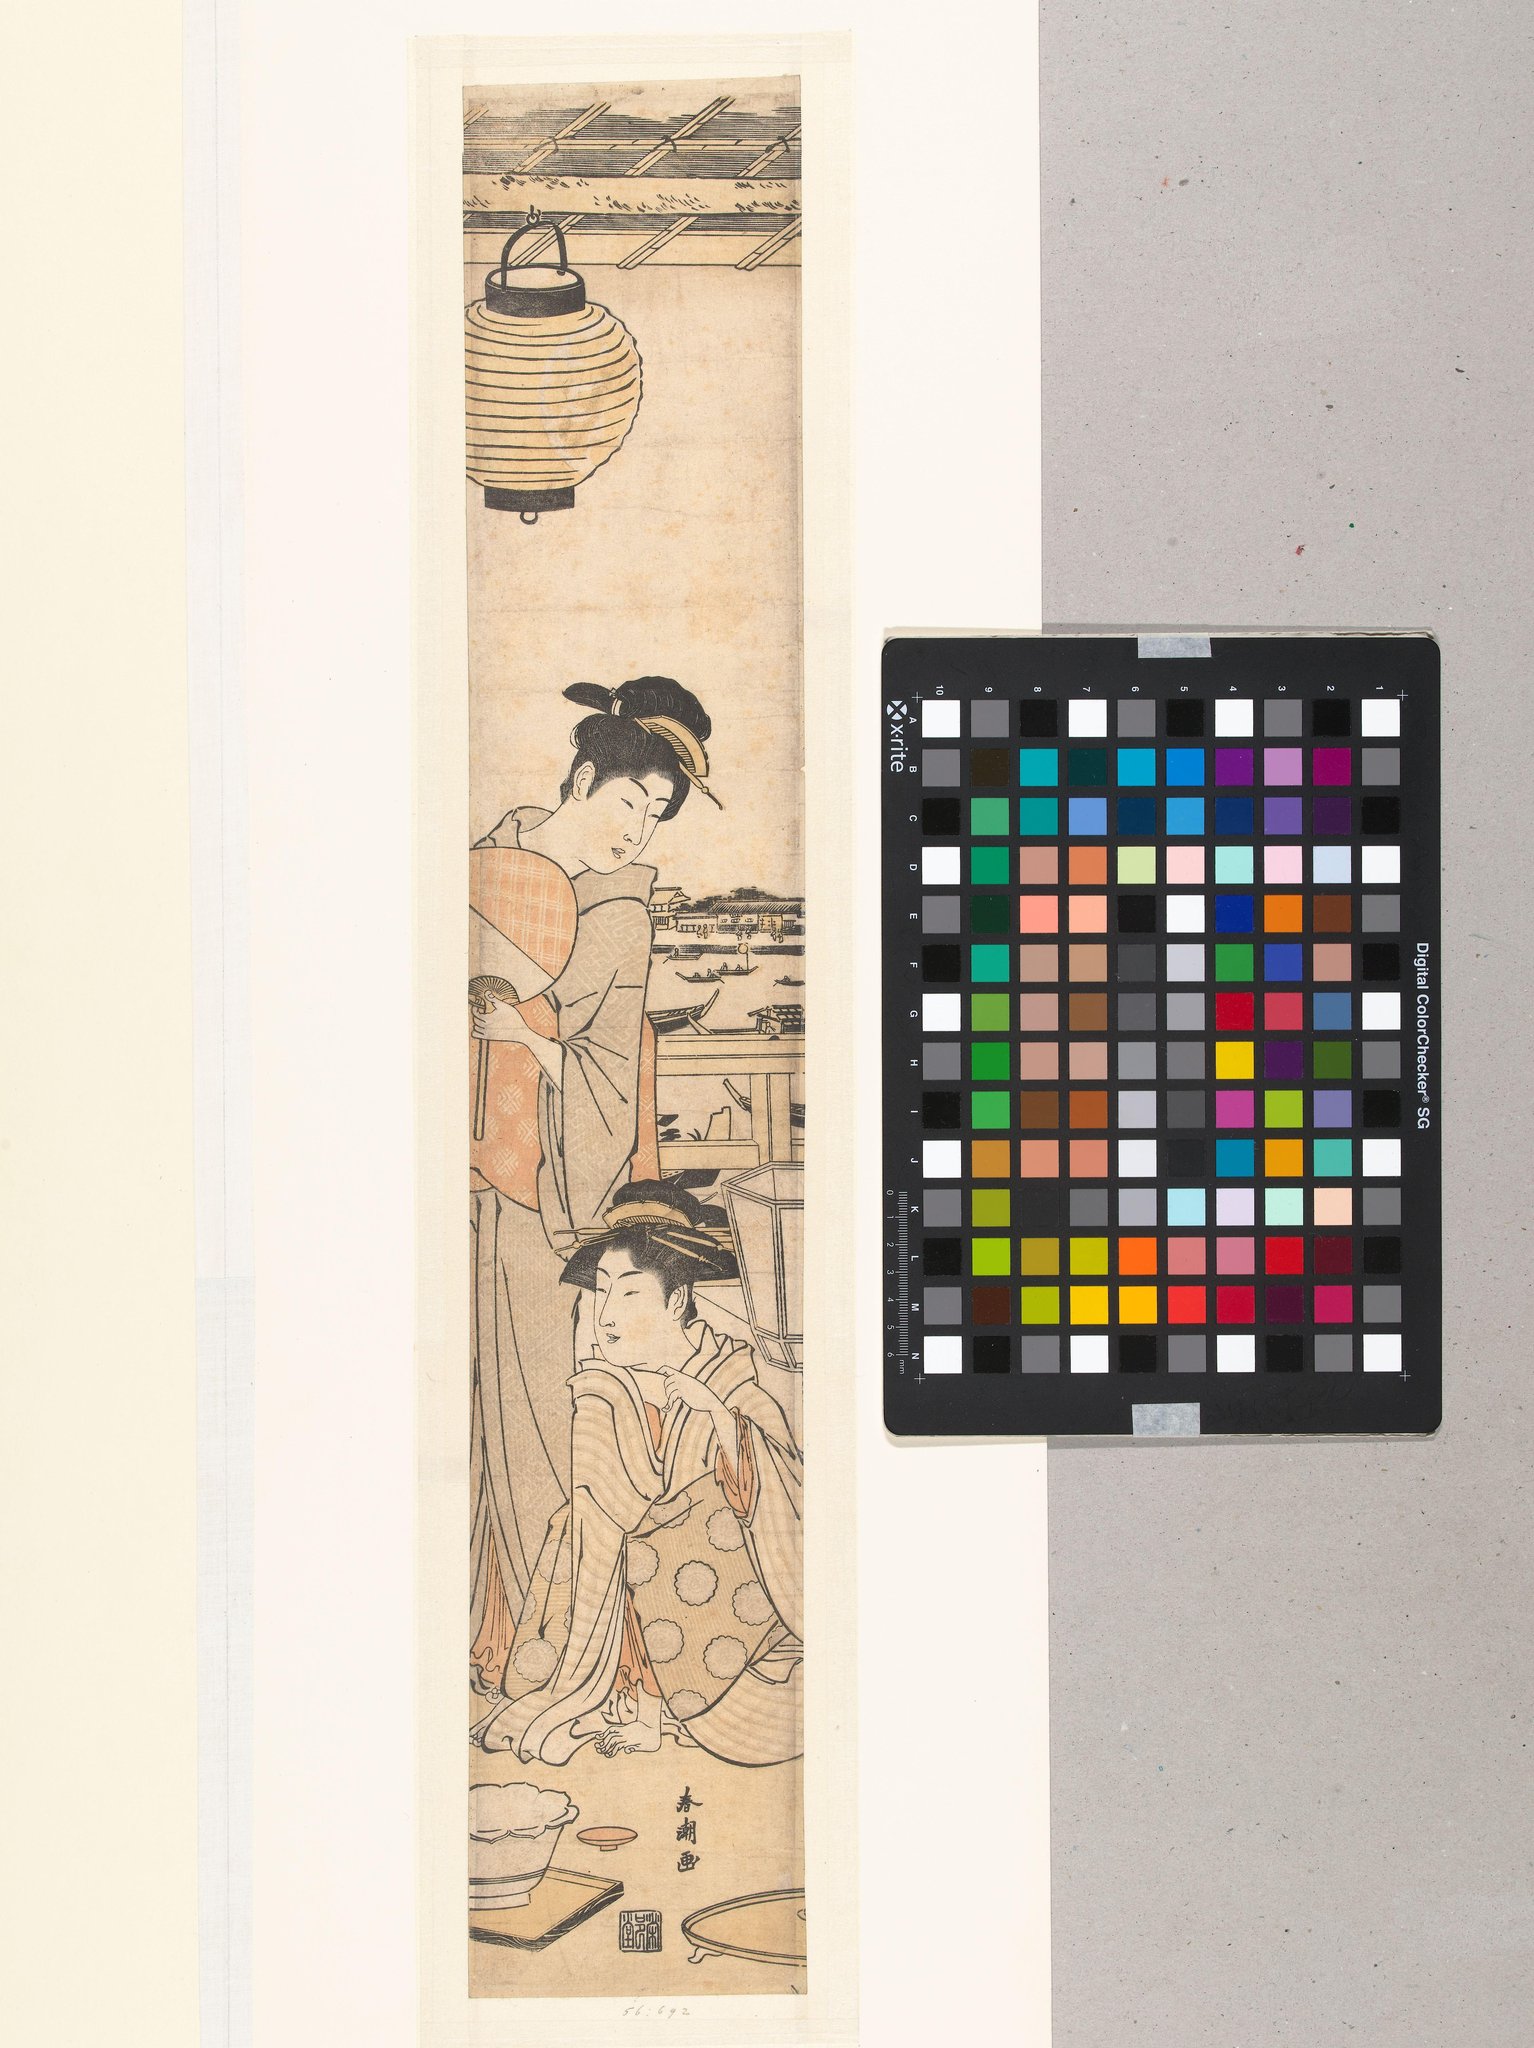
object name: print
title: Twee courtisanes op het balkon van een theehuis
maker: katsukawa shunchō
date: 1780-1790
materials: paper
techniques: woodcut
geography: tokyo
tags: courtesan, hetaera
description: Staande en zittende courtisane, onder lampion, op balkon met uitzicht op theehuizen langs de oever van de Sumida rivier, vol met bootjes op de achtergrond.